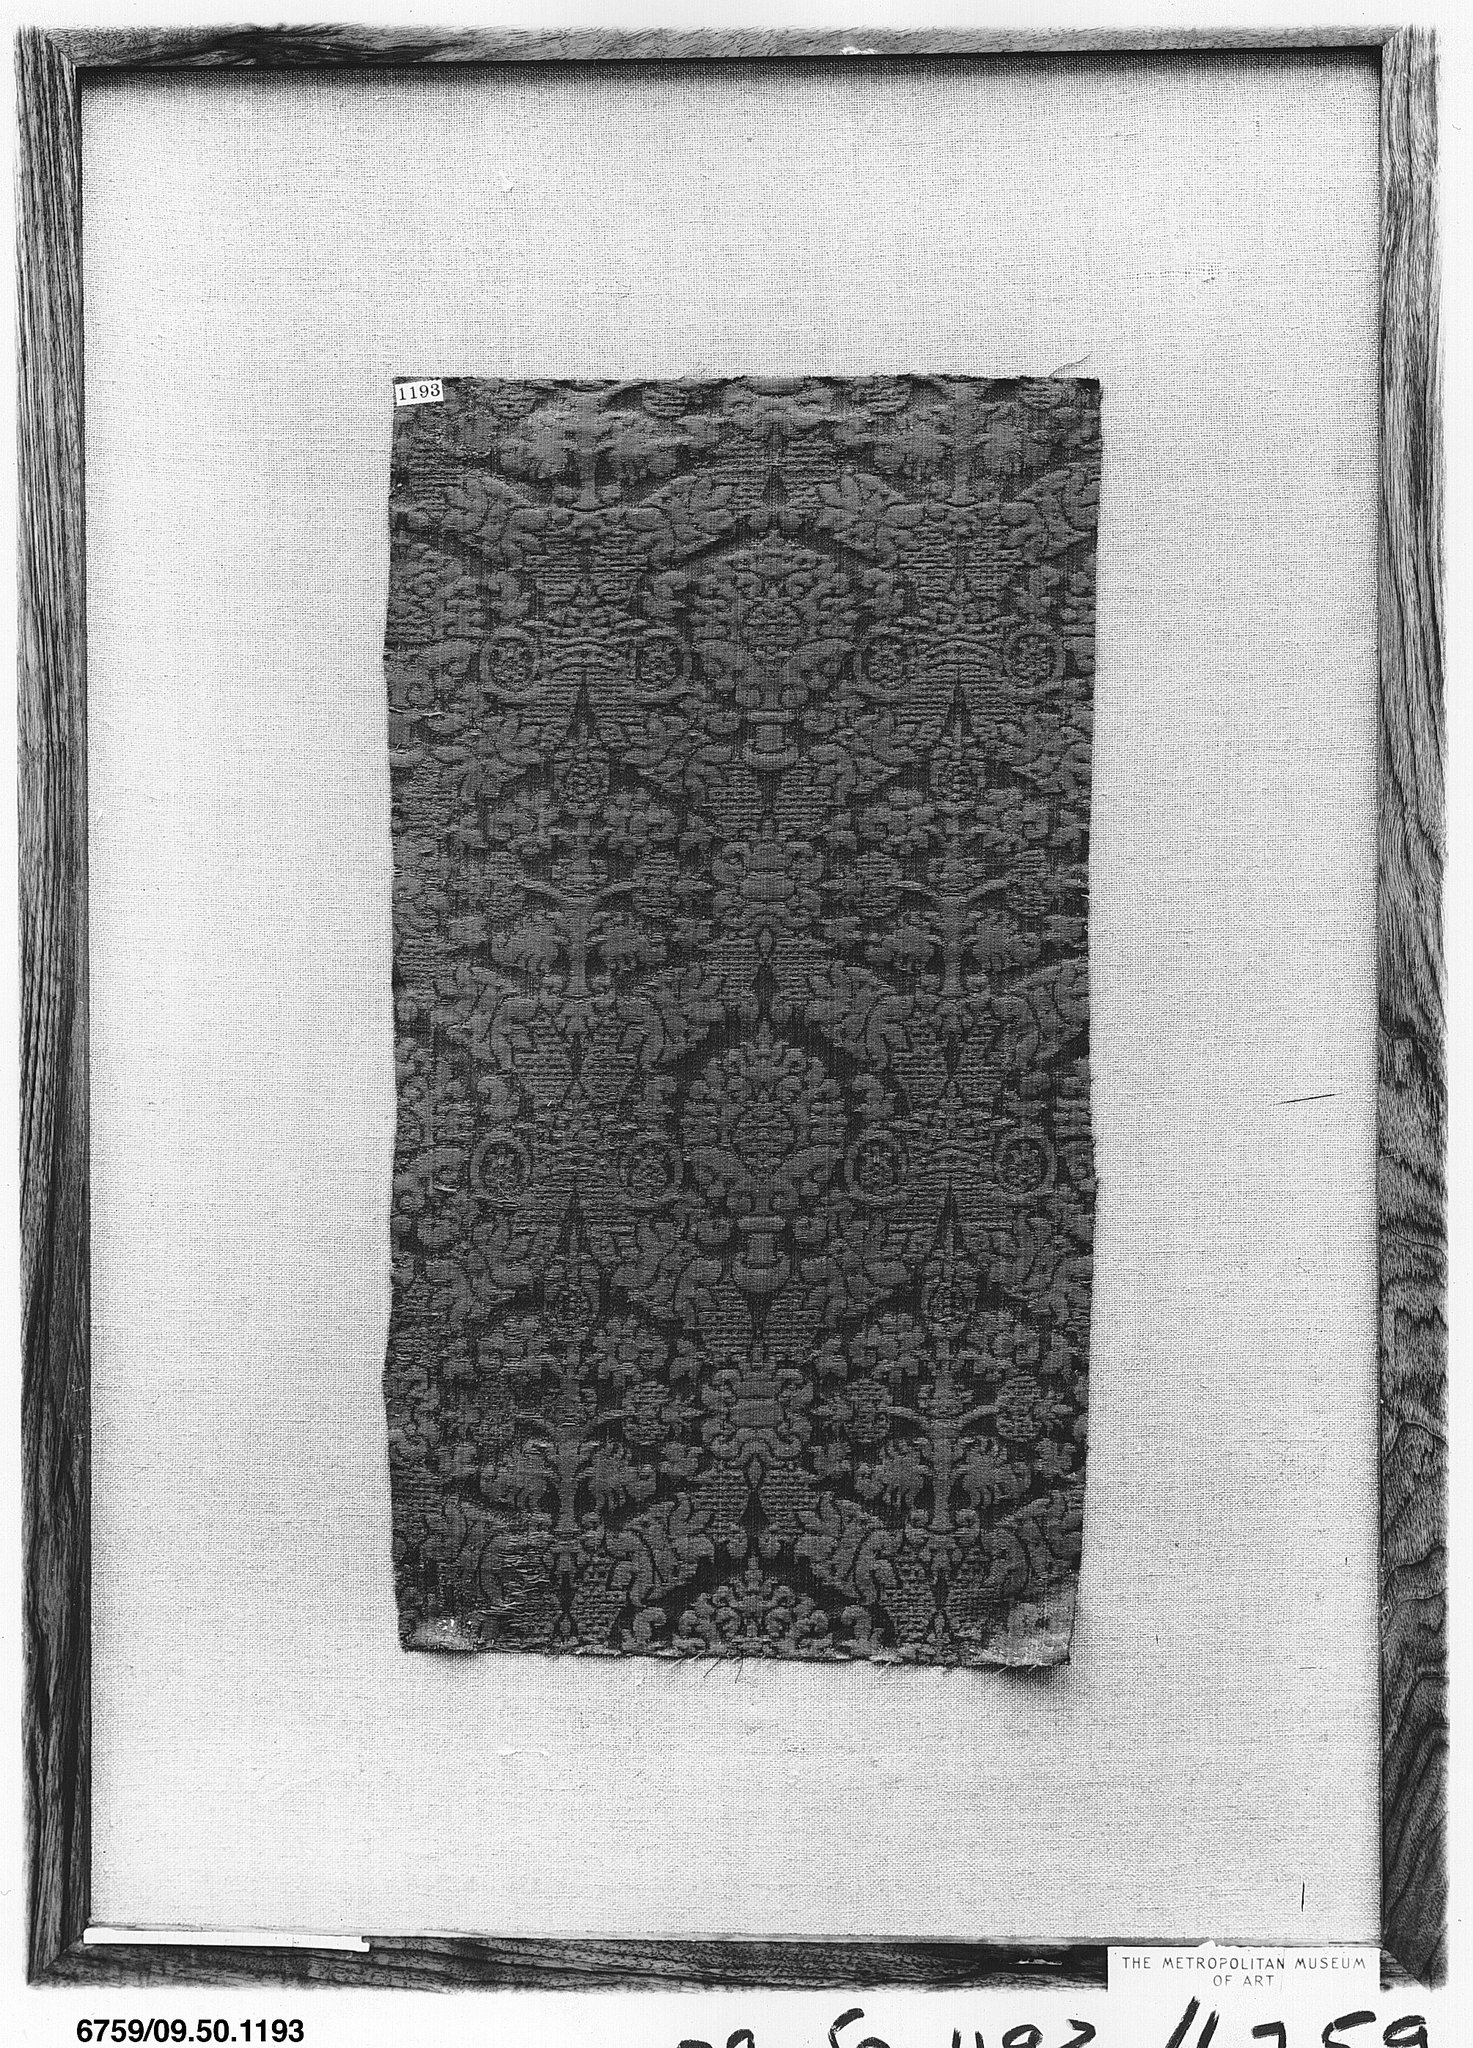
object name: piece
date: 1501-1700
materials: silk